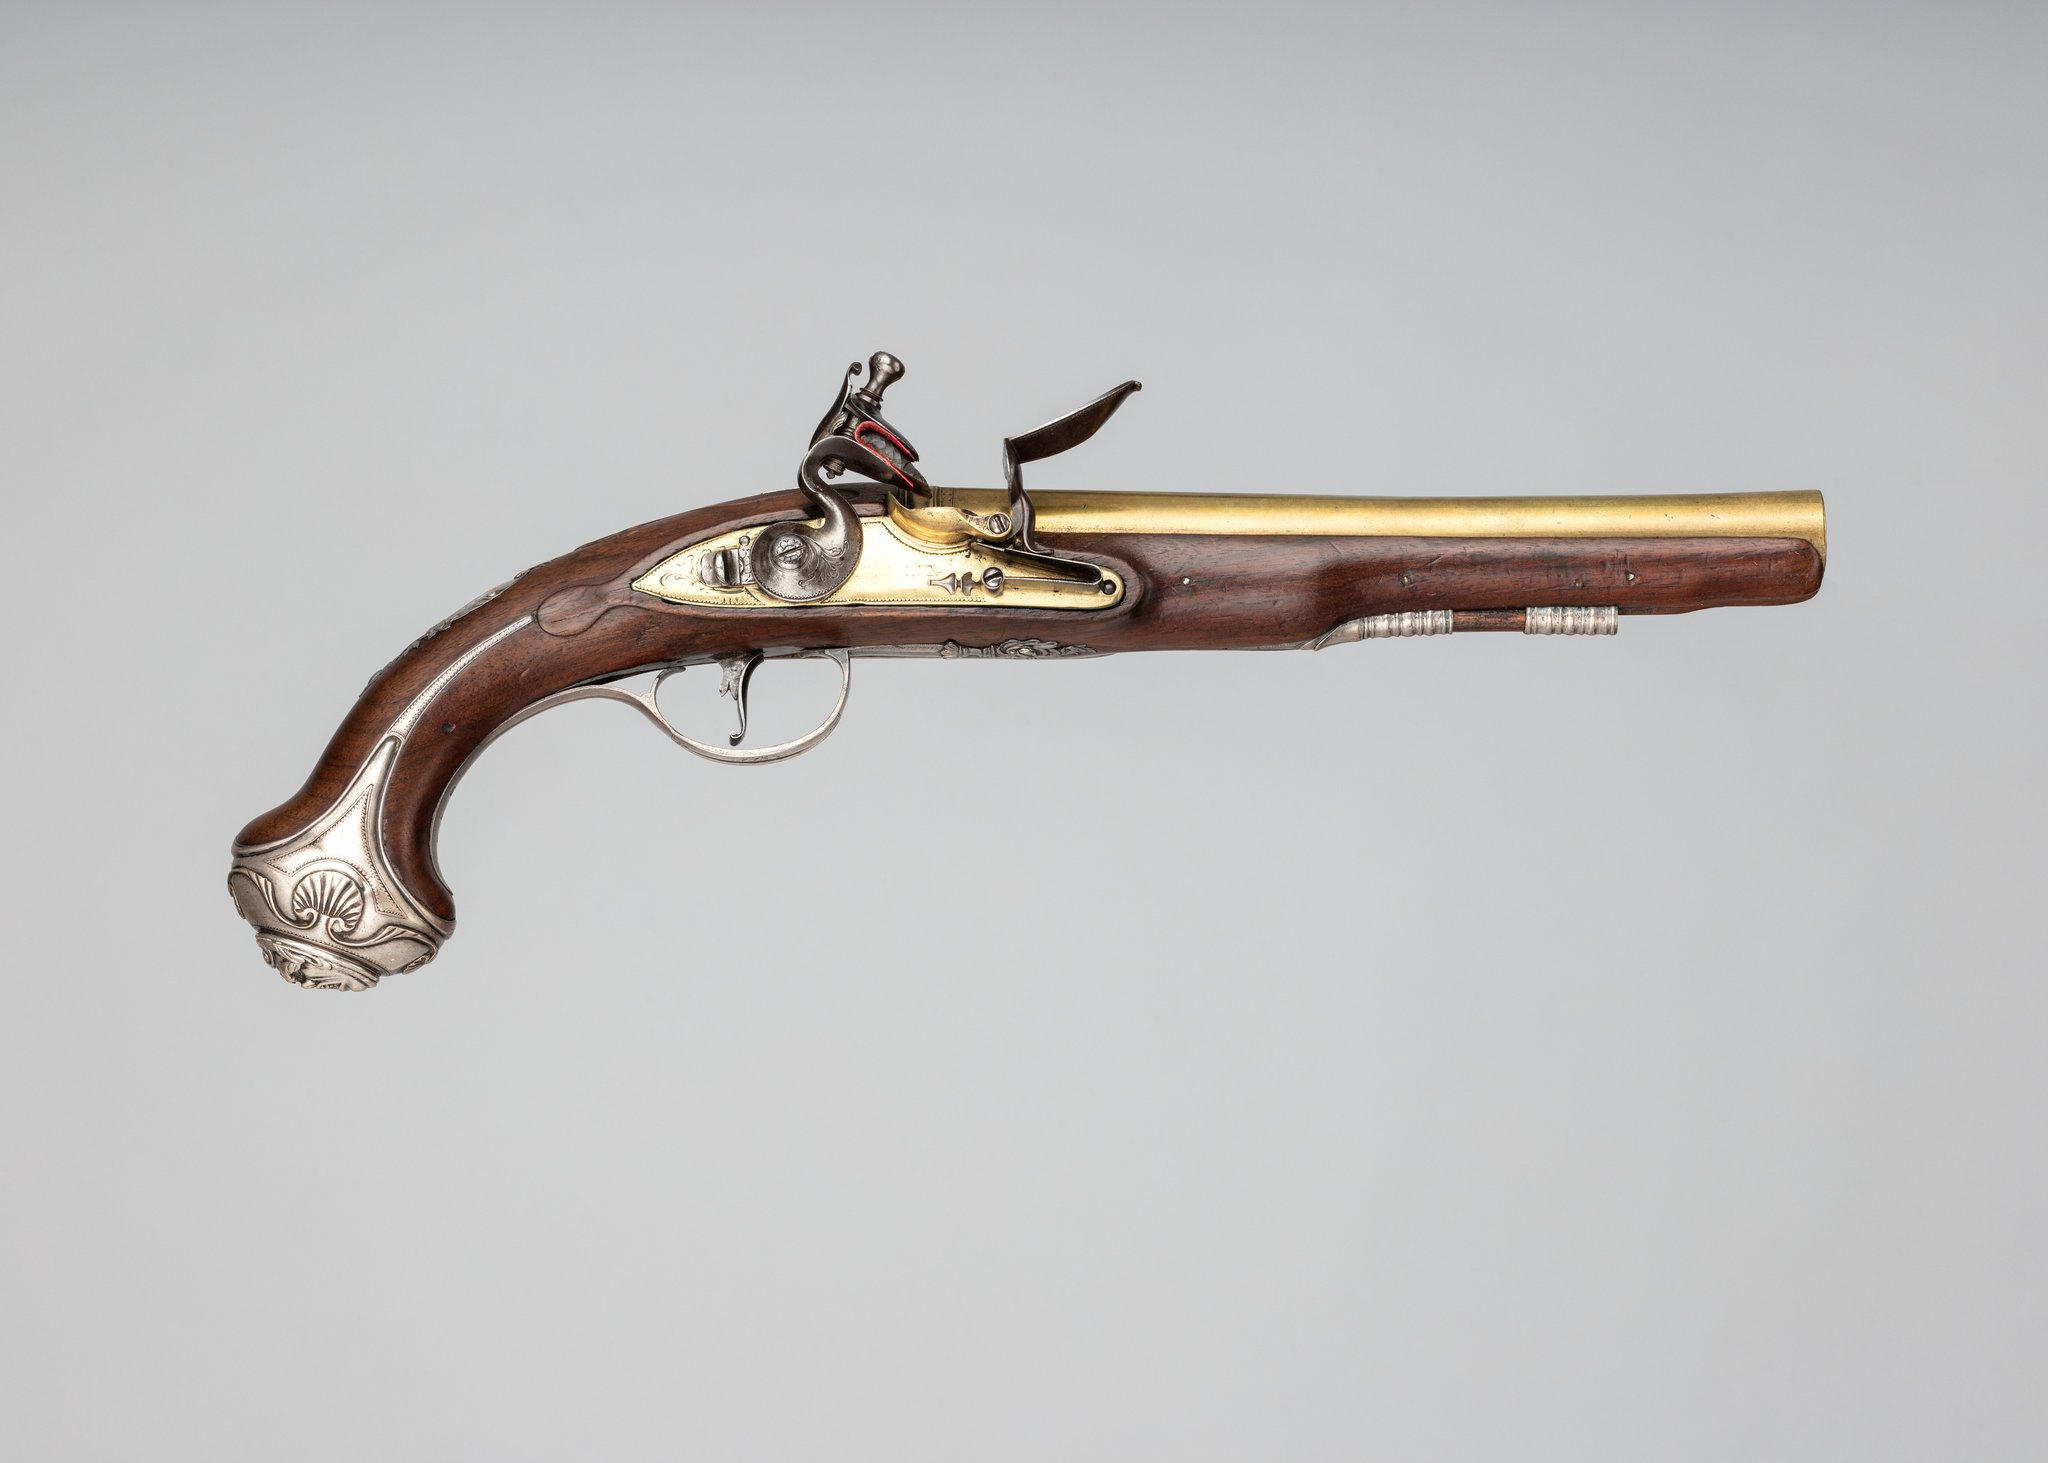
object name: flintlock pistol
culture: british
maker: john hall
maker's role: barrelsmith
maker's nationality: british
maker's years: 1738-1800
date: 1771-1772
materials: brass, silver, steel, wood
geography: britain